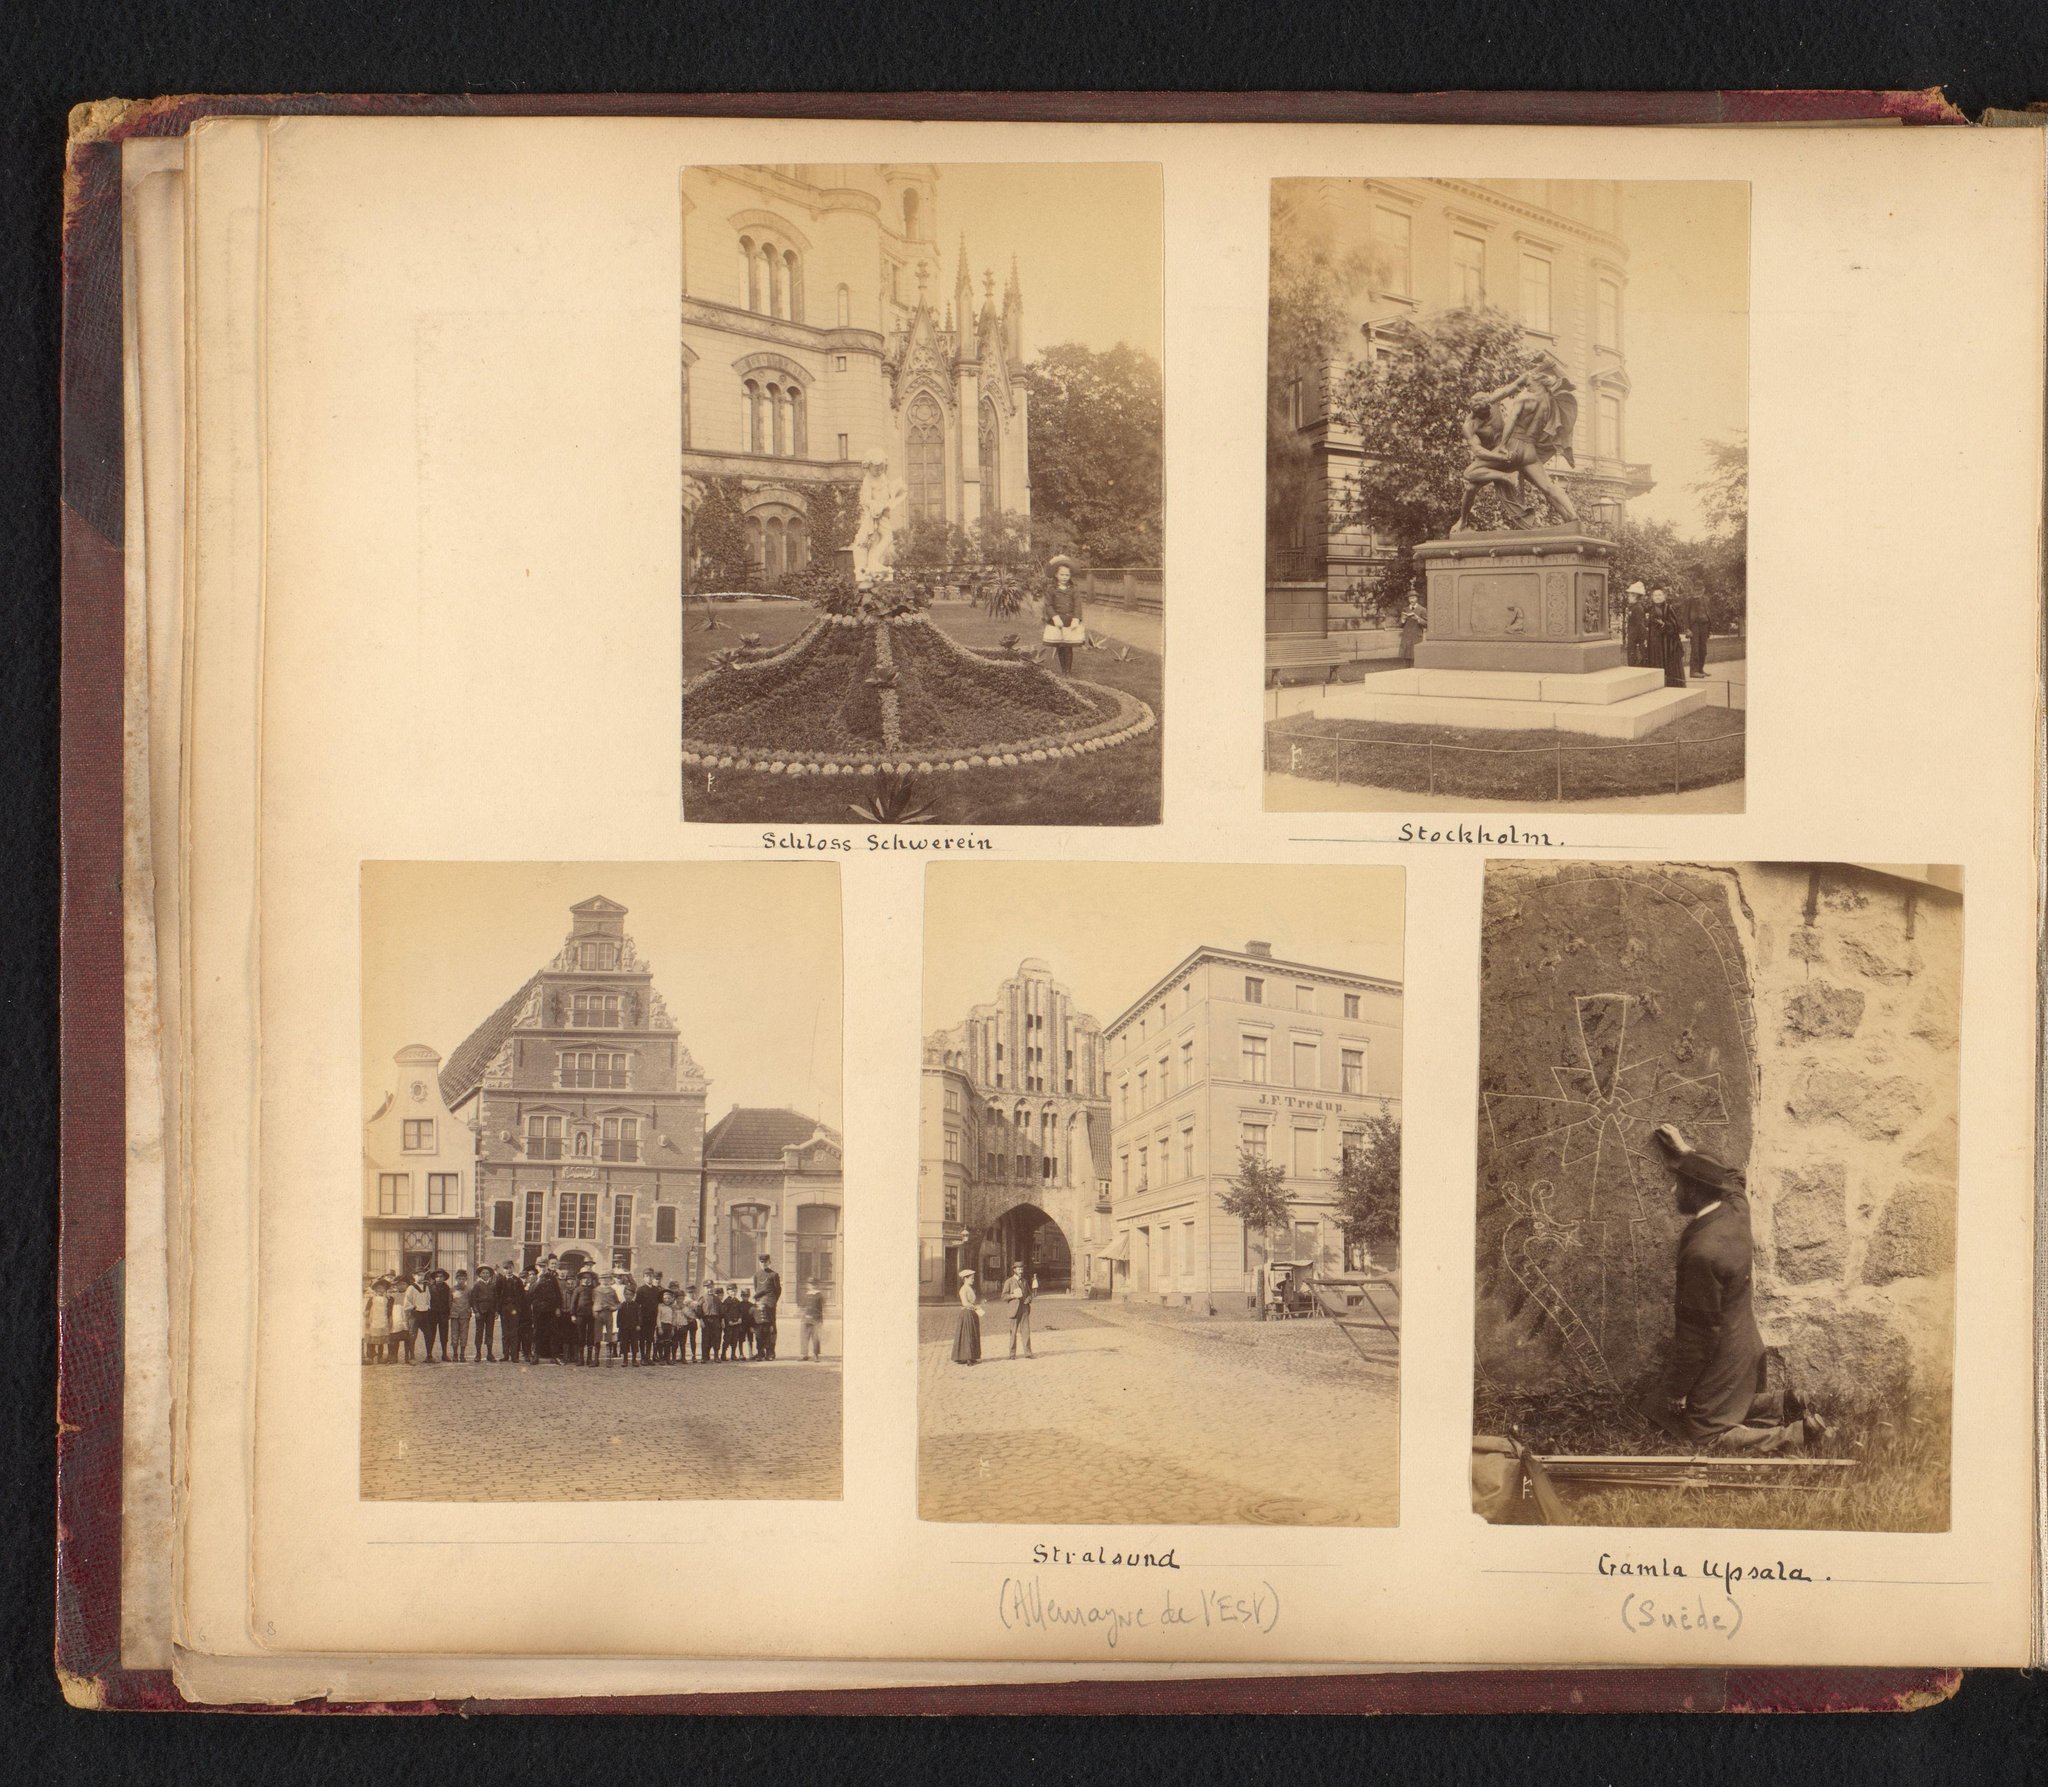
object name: album leaf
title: Gezichten op plaatsen in Zweden en Duitsland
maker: Anonymous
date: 1880-1897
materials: photographic support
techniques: albumen print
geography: europe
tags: historical persons, monument, statue, civic architecture; edifices; dwellings, anonymous historical persons portrayed in a group, in a group-portrait, germany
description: Gezicht op een monument in Stockholm, een groepsportret voor een gebouw, en volgens de opschriften een meisje voor Schloss Schwerein, een man en vrouw te Stalsund en een tekenende man in Gamla Uppsala. Deze pagina maakt deel uit van een album.